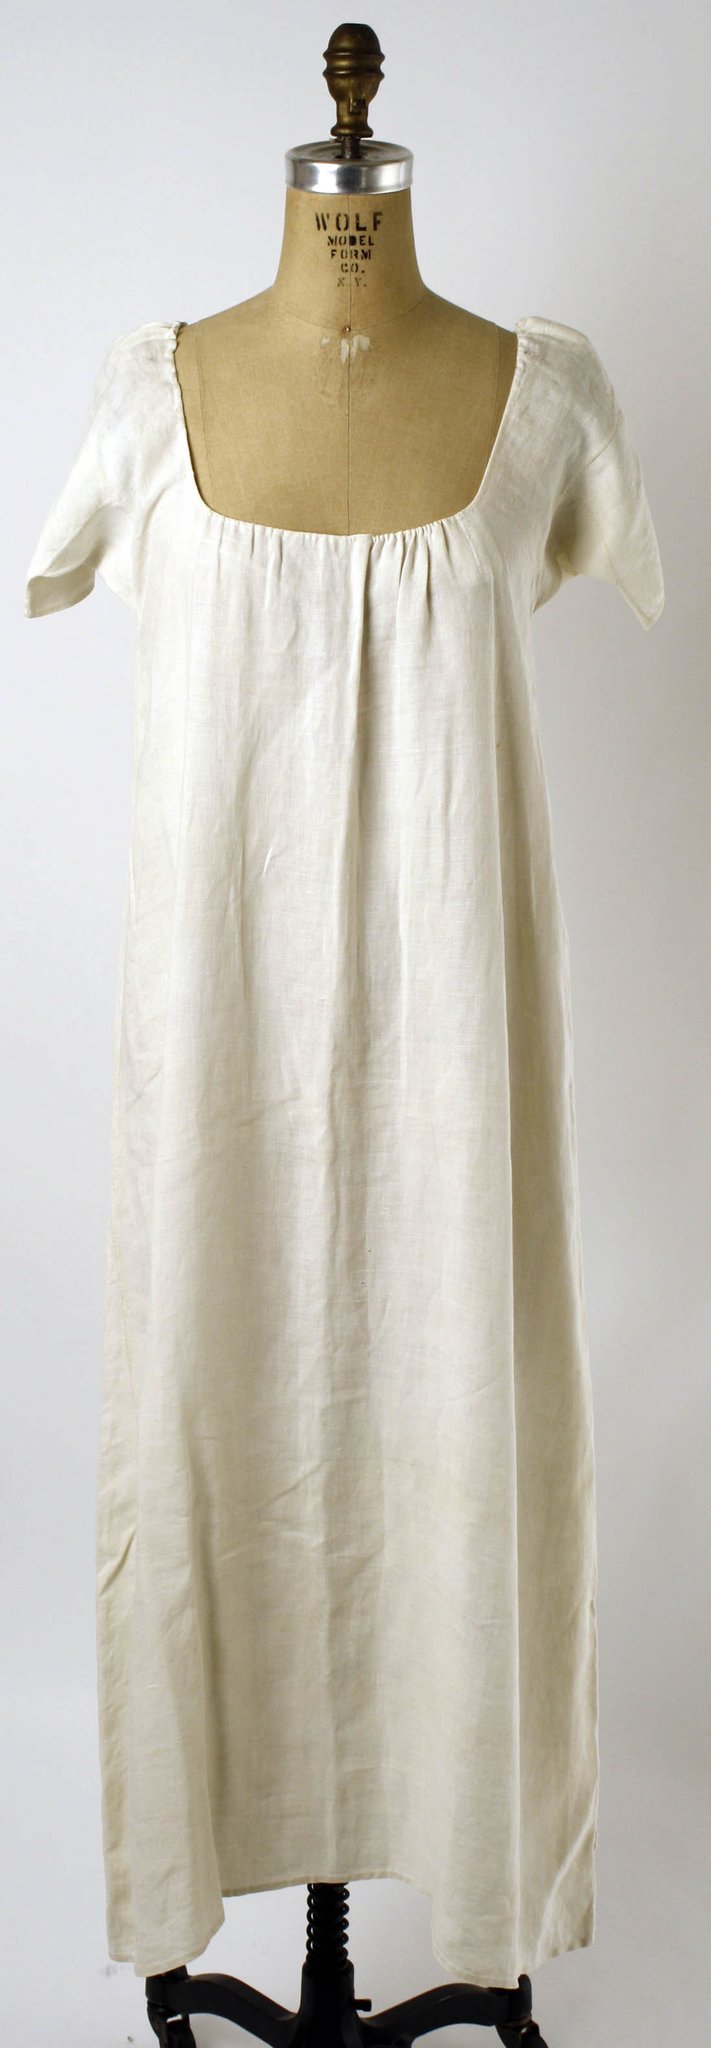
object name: chemise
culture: french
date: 1751-1775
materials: linen